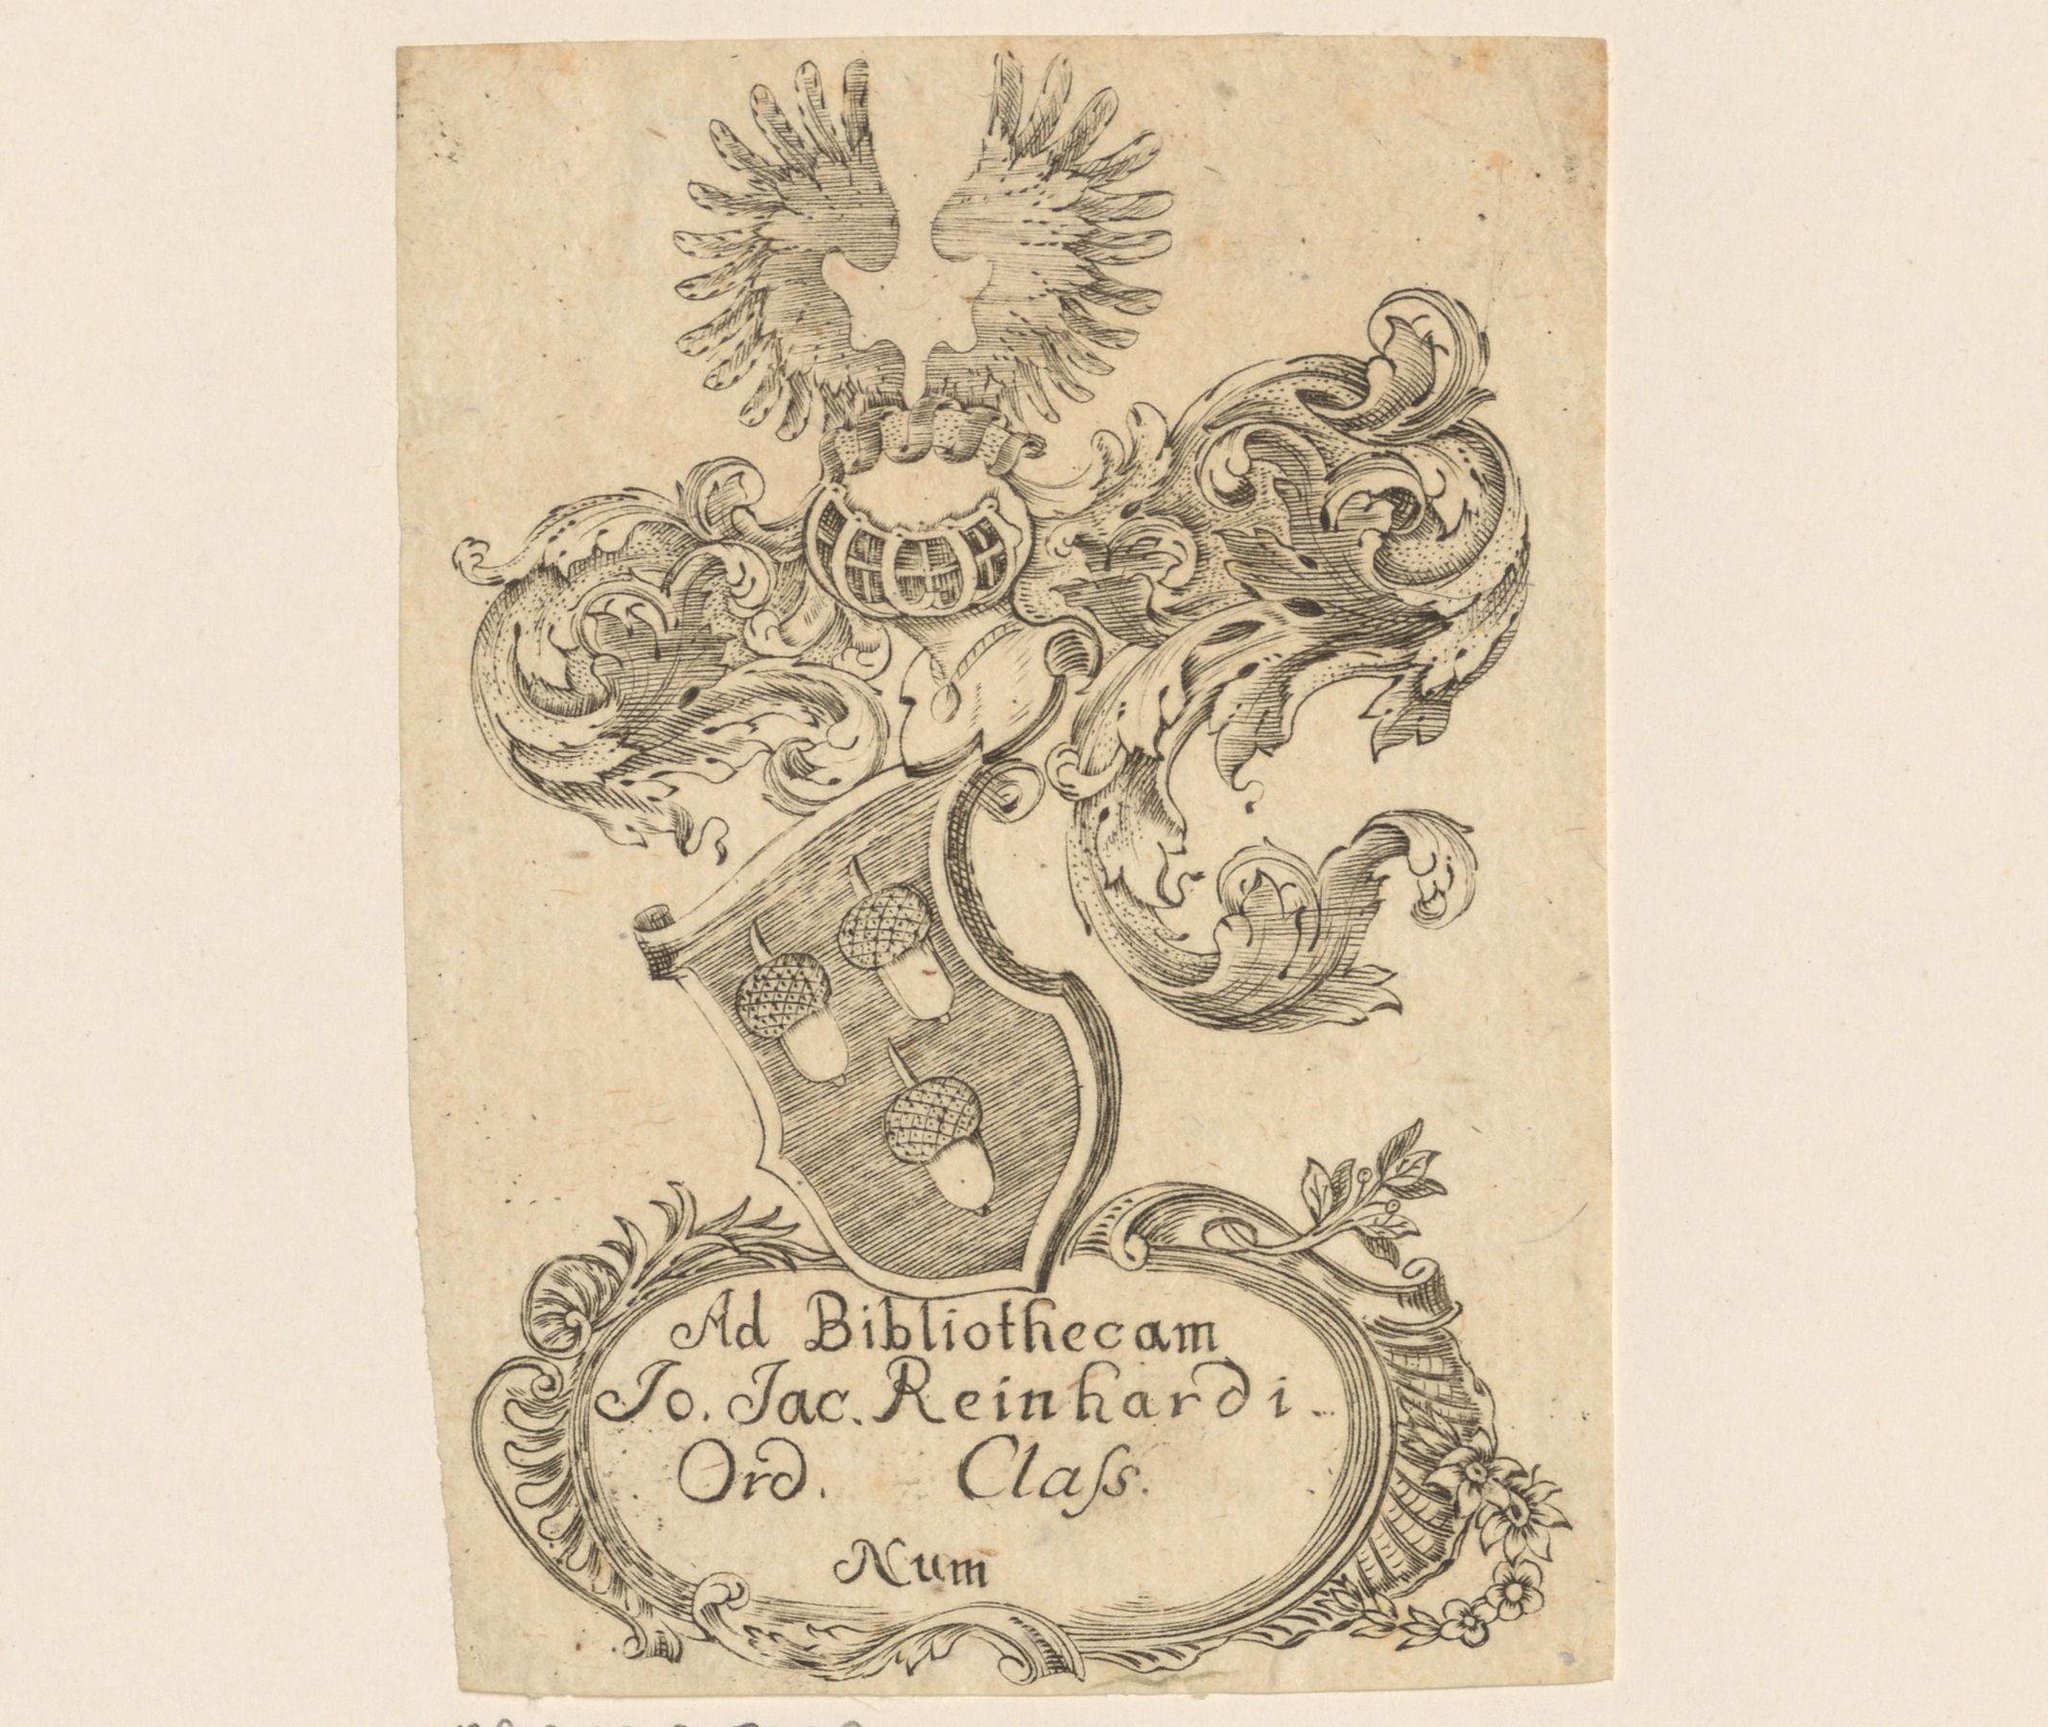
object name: bookplate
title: Ex libris van Johann Jacob Reinhardt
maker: Anonymous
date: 1724-1772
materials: paper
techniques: etching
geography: germany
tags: armorial bearing, heraldry, fruits: acorn